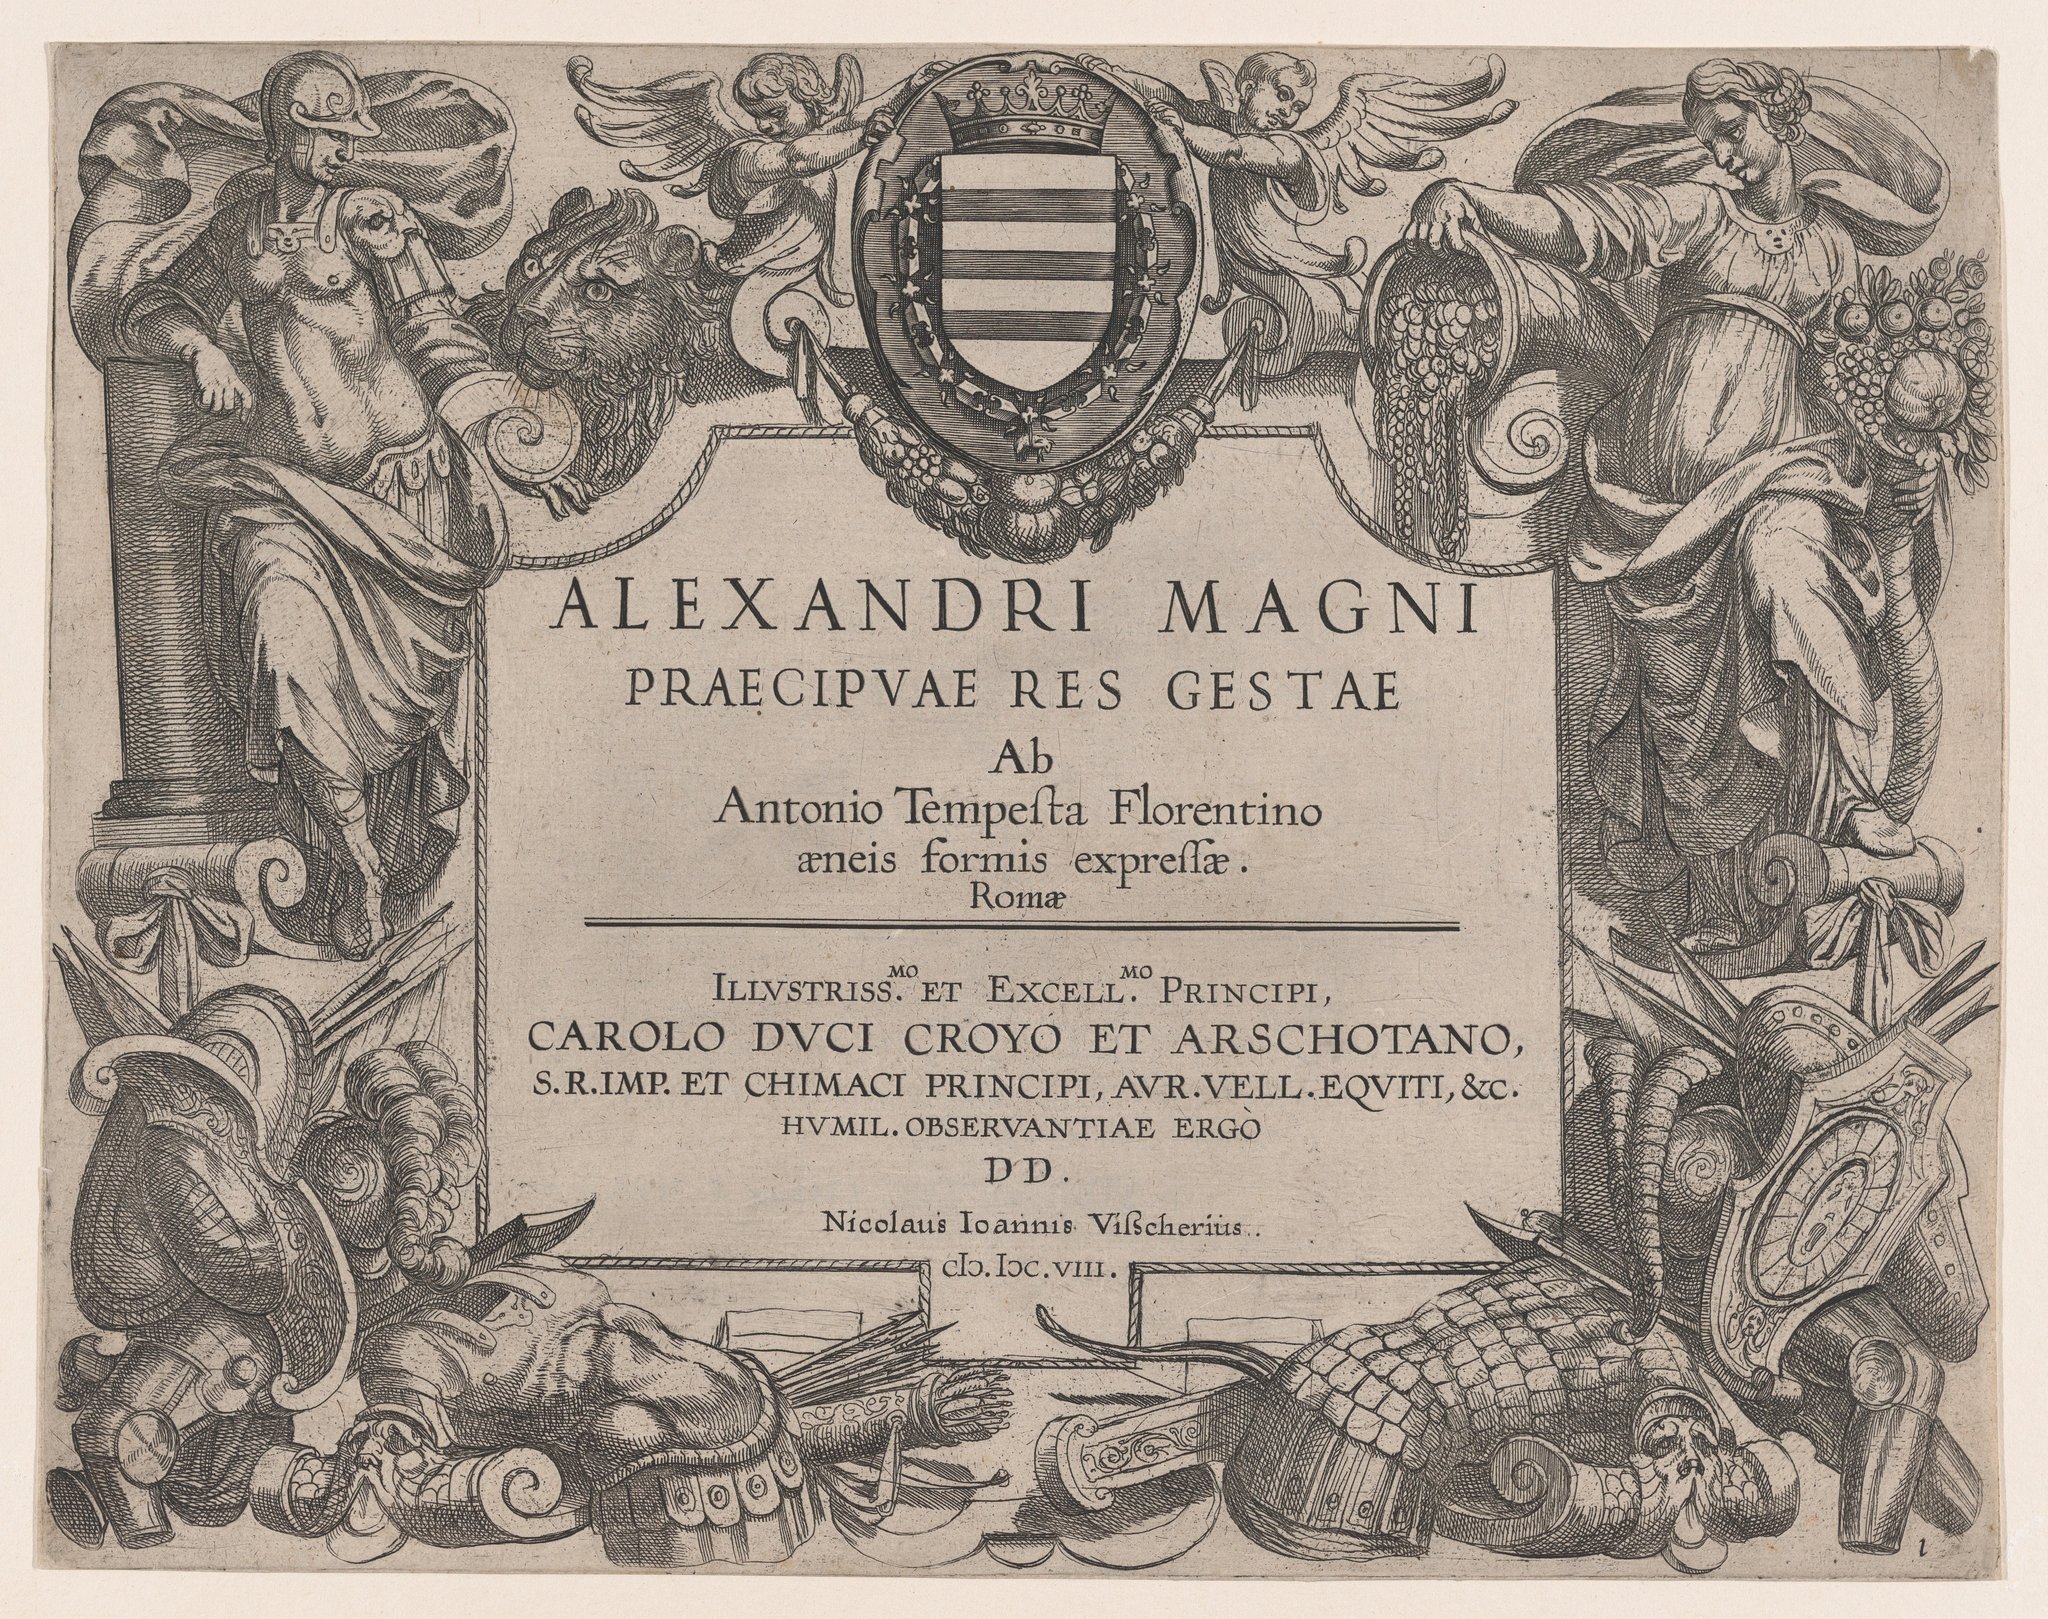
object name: print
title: Frontispiece to the life of Alexander the Great, at left is Bellona and at right a female personification of abundance, the Coat of Arms of the Duke of Croy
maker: antonio tempesta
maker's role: artist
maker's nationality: italian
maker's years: 1555-1630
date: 1608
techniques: etching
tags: armor,men,women,coat of arms